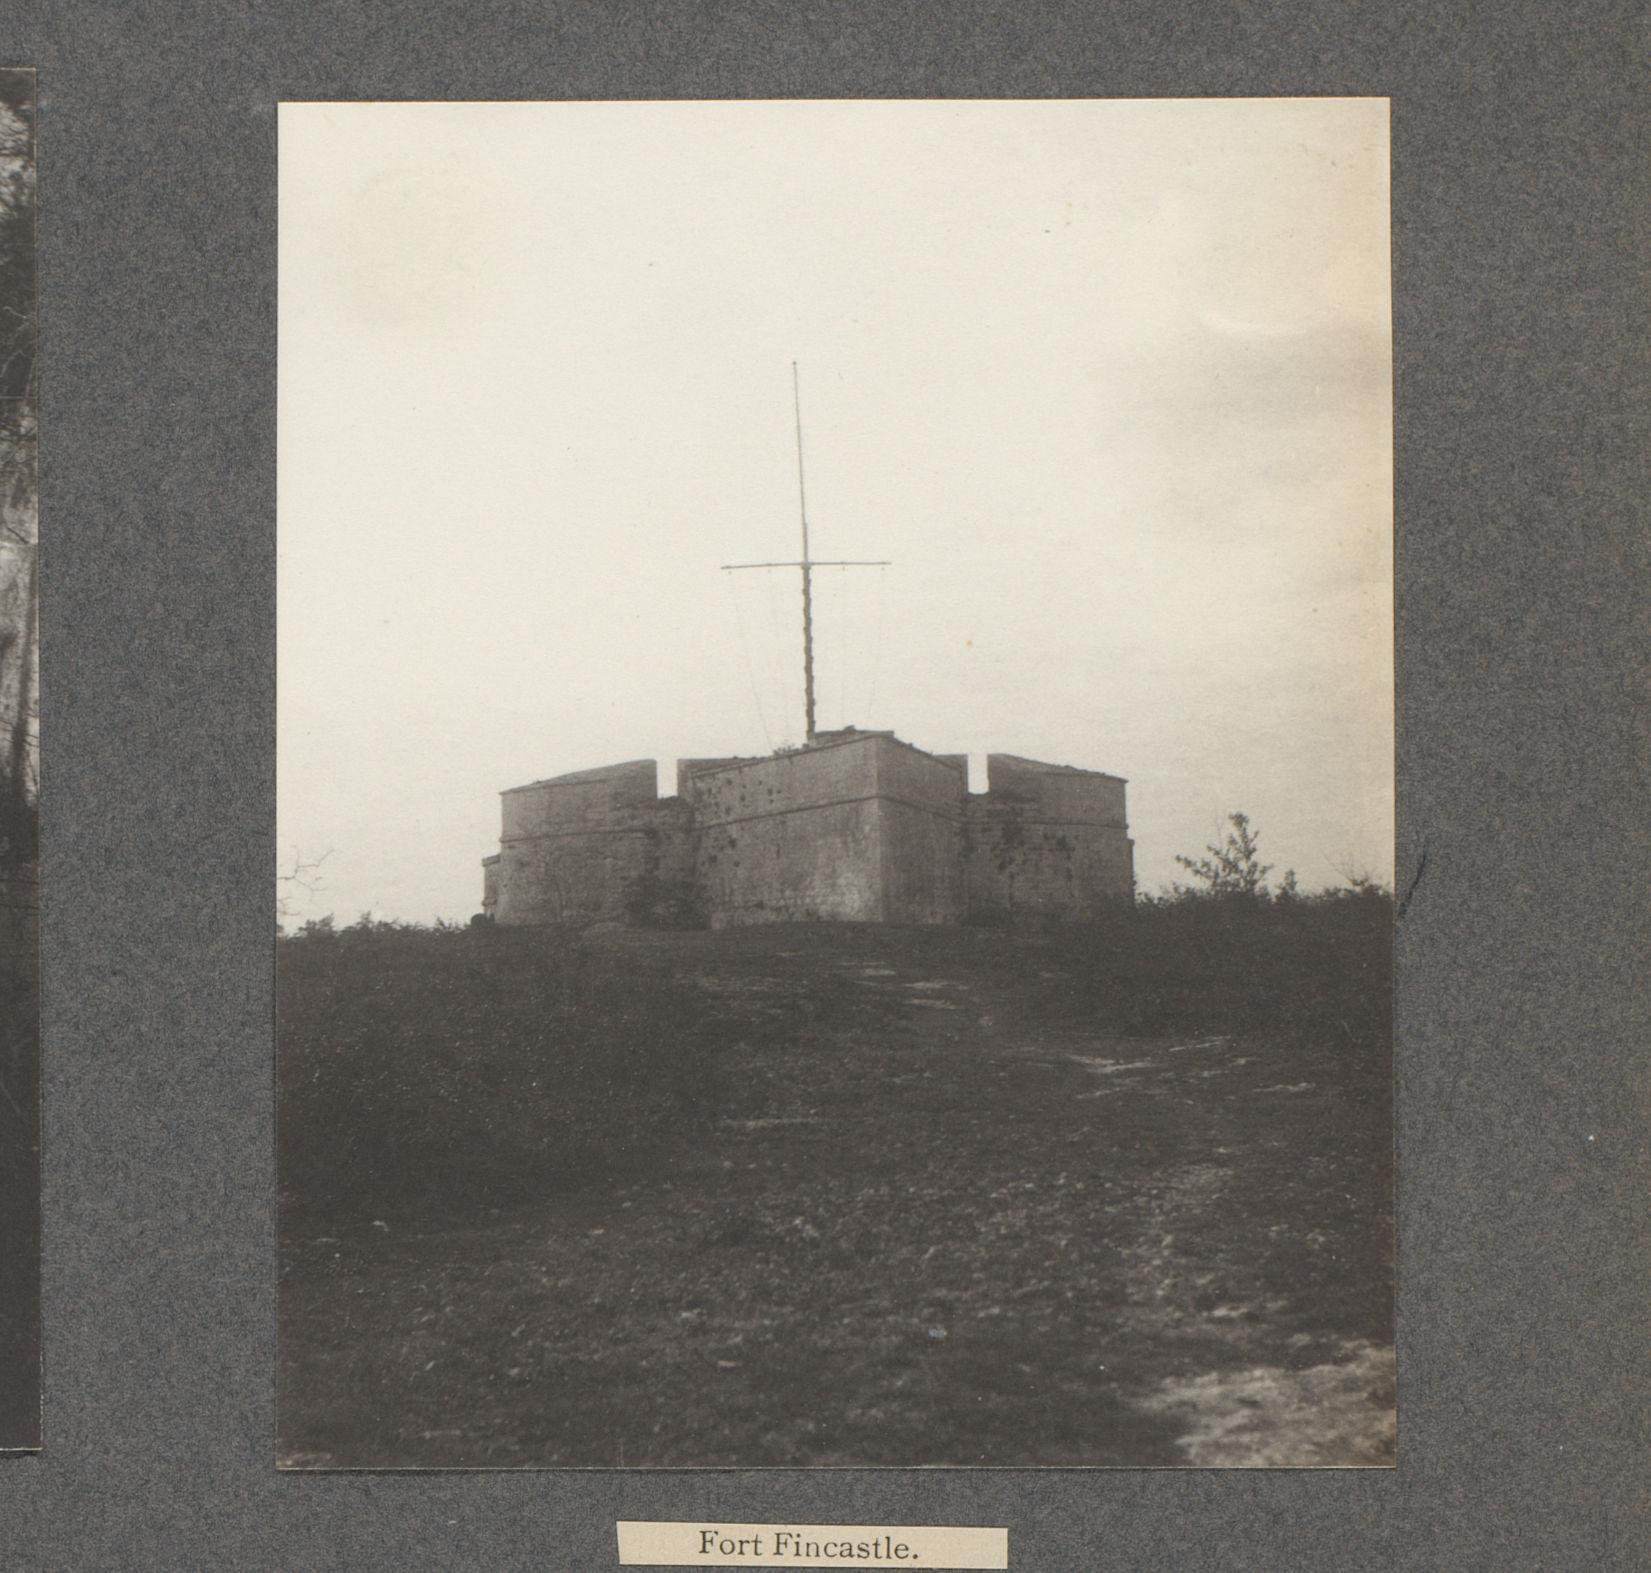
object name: photograph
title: Gezicht op Fort Fincastle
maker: Anonymous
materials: paper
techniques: platinum process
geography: nassau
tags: fortified city